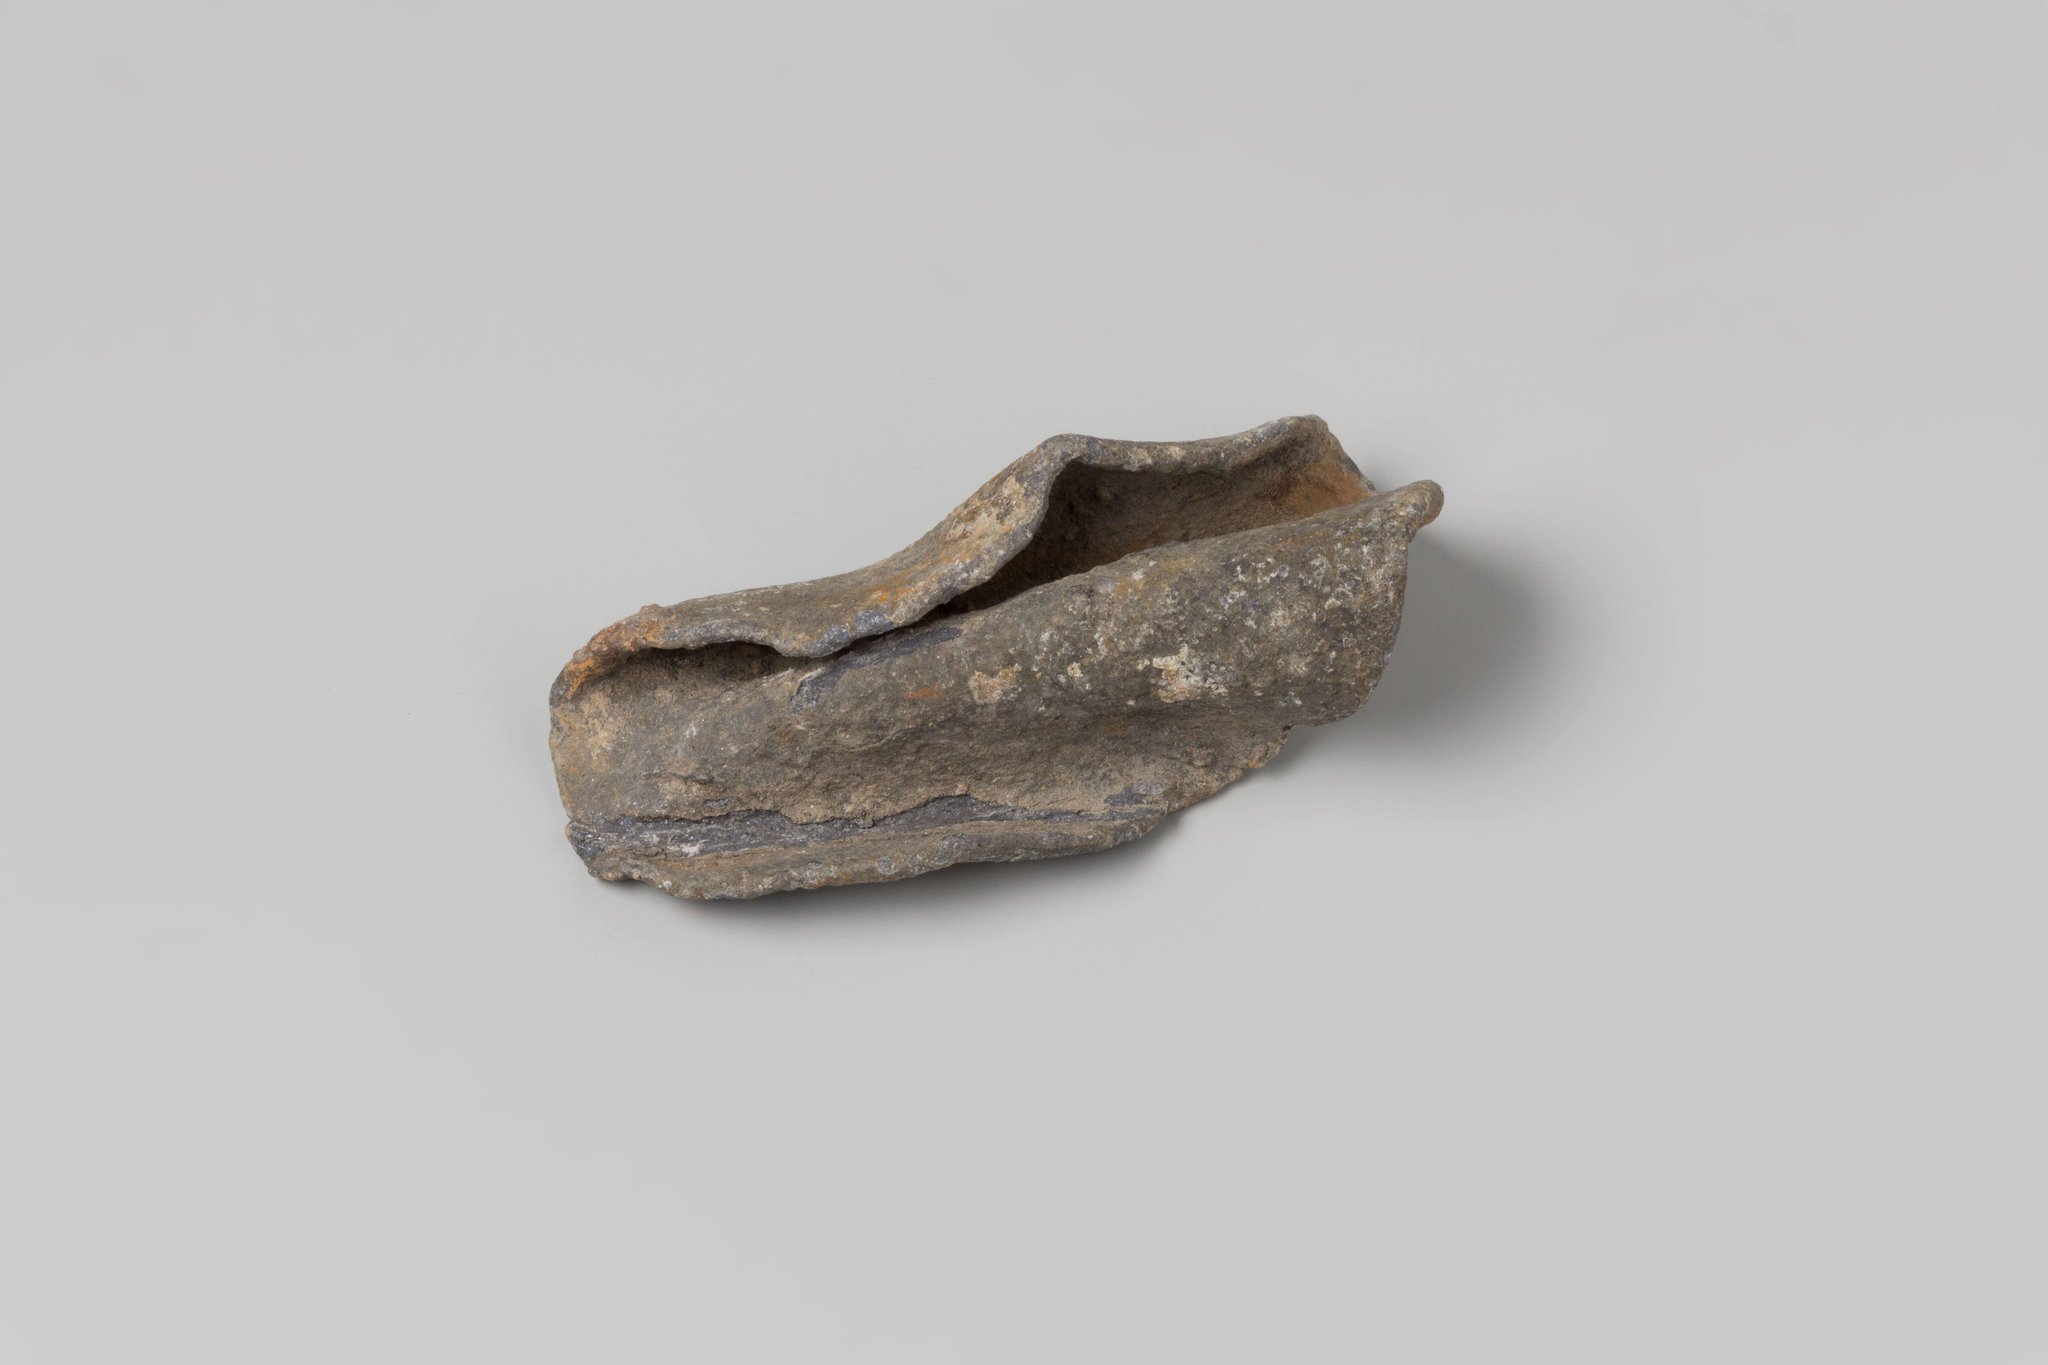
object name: scheepswrakvondst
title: Scheepswrakvondst uit het wrak van de Oost-Indiëvaarder Hollandia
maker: Anonymous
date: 1700-1743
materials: lead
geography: netherlands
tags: verenigde oostindische compagnie, hollandia (schip), annet